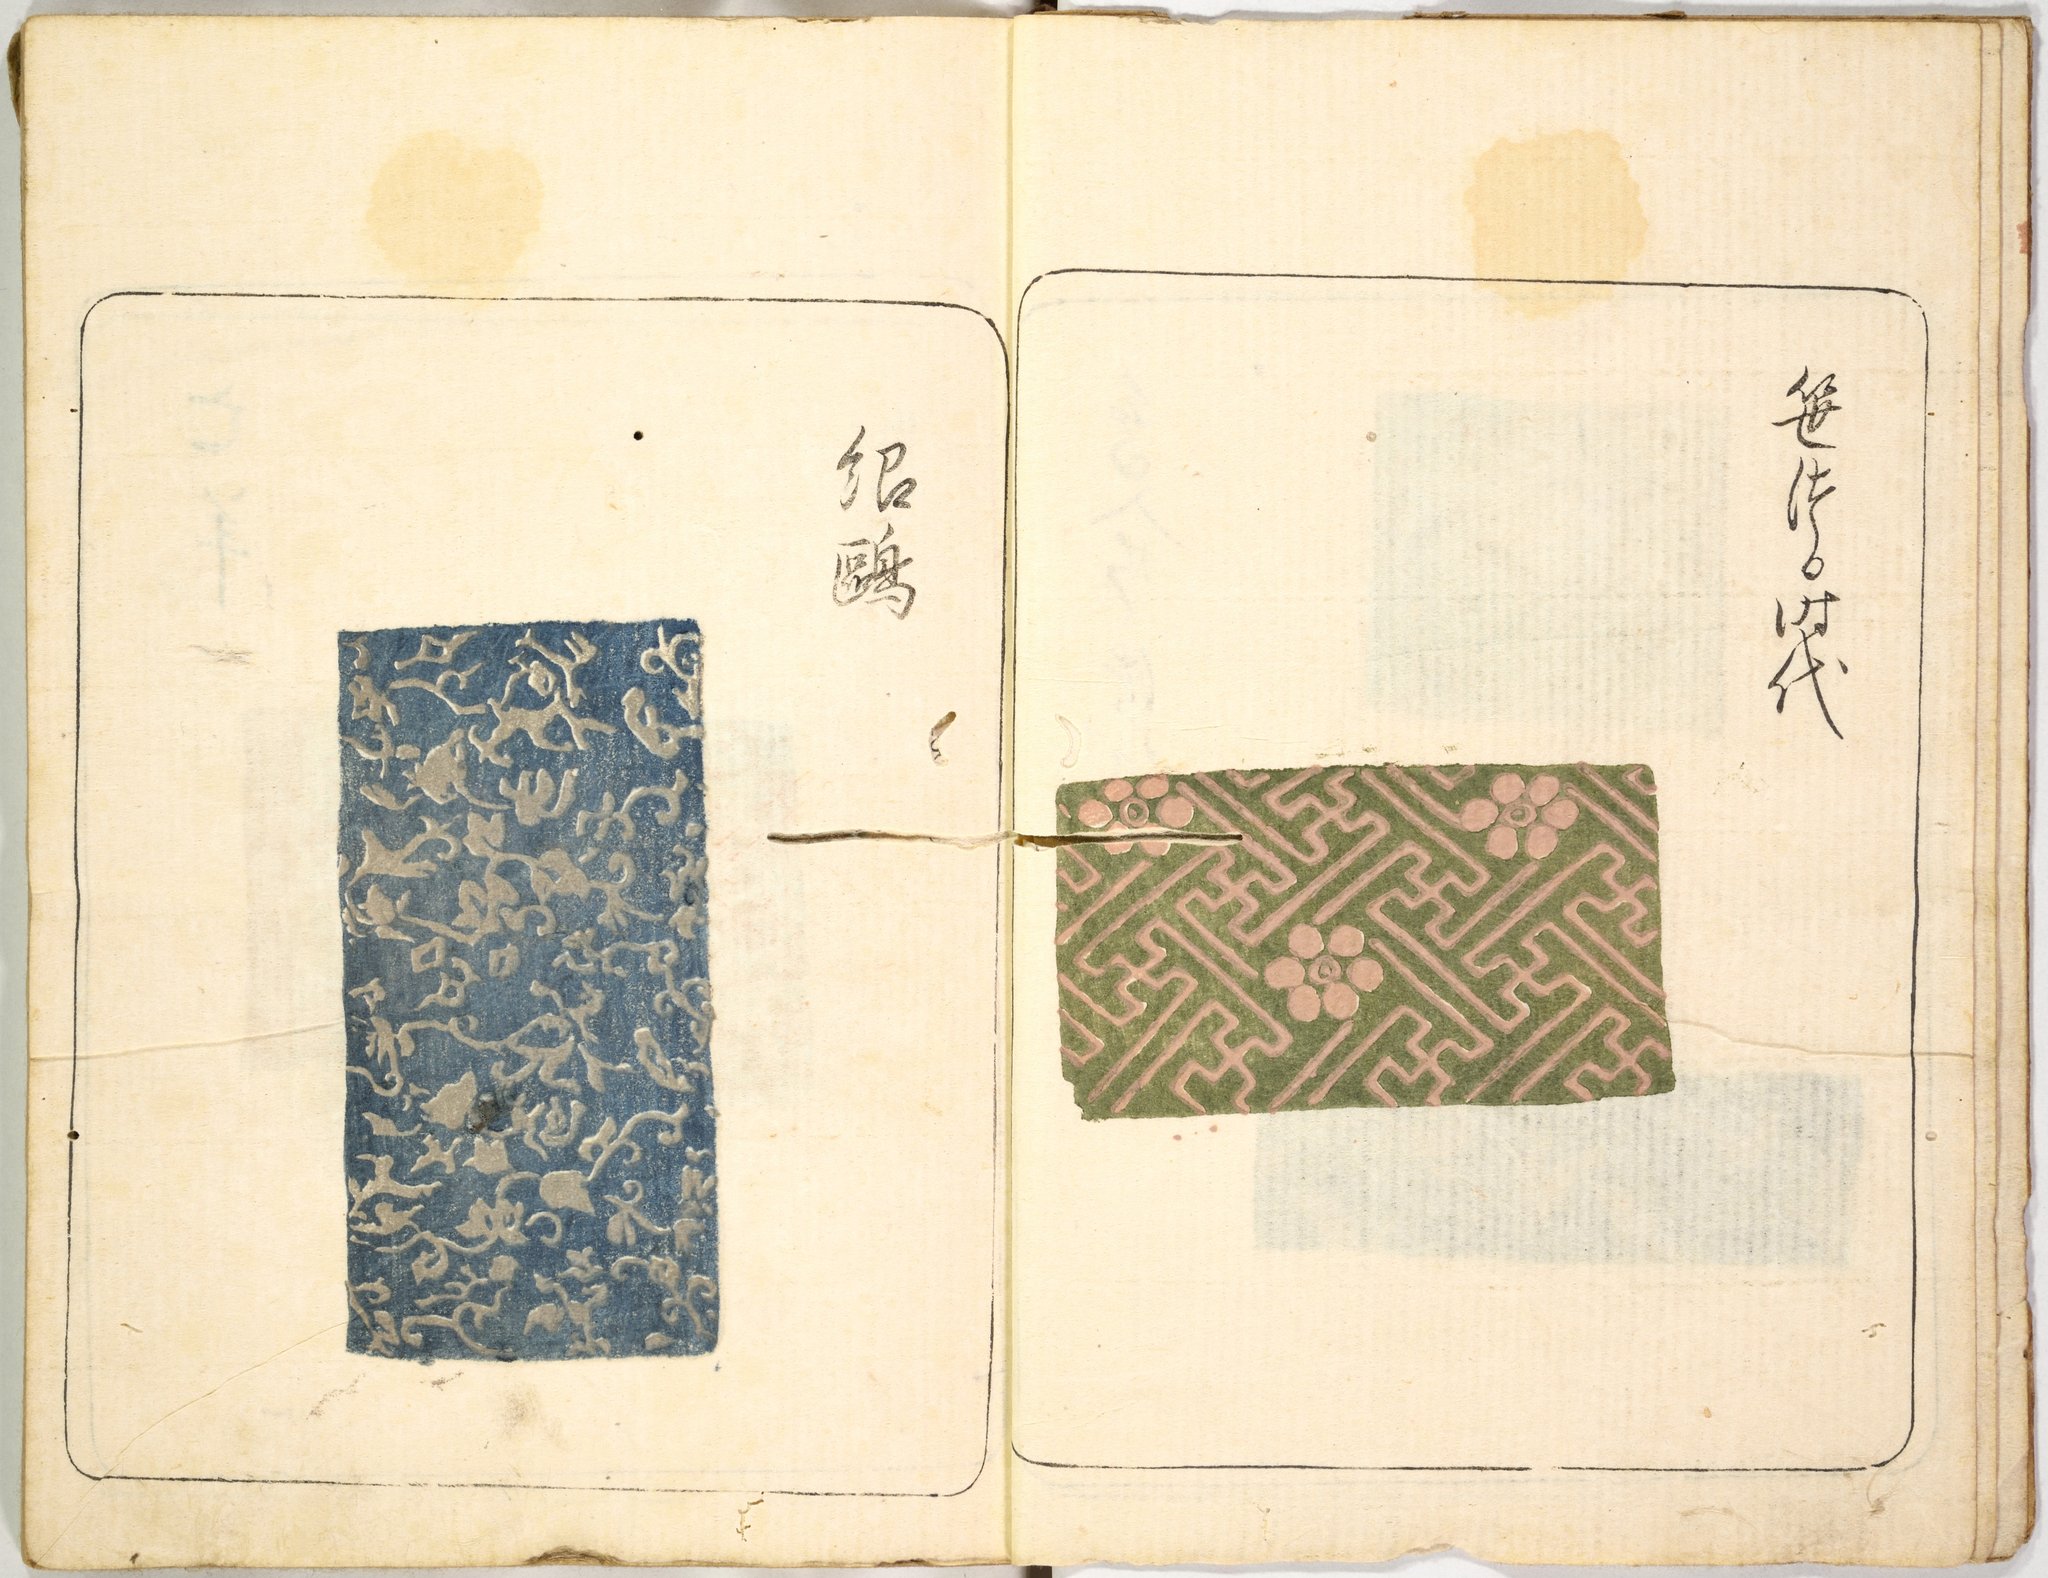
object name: illustrated book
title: Kokon meibutsu rui shū, Vol. 1 (examples of old textile designs)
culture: japanese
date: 1789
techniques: woodblock print